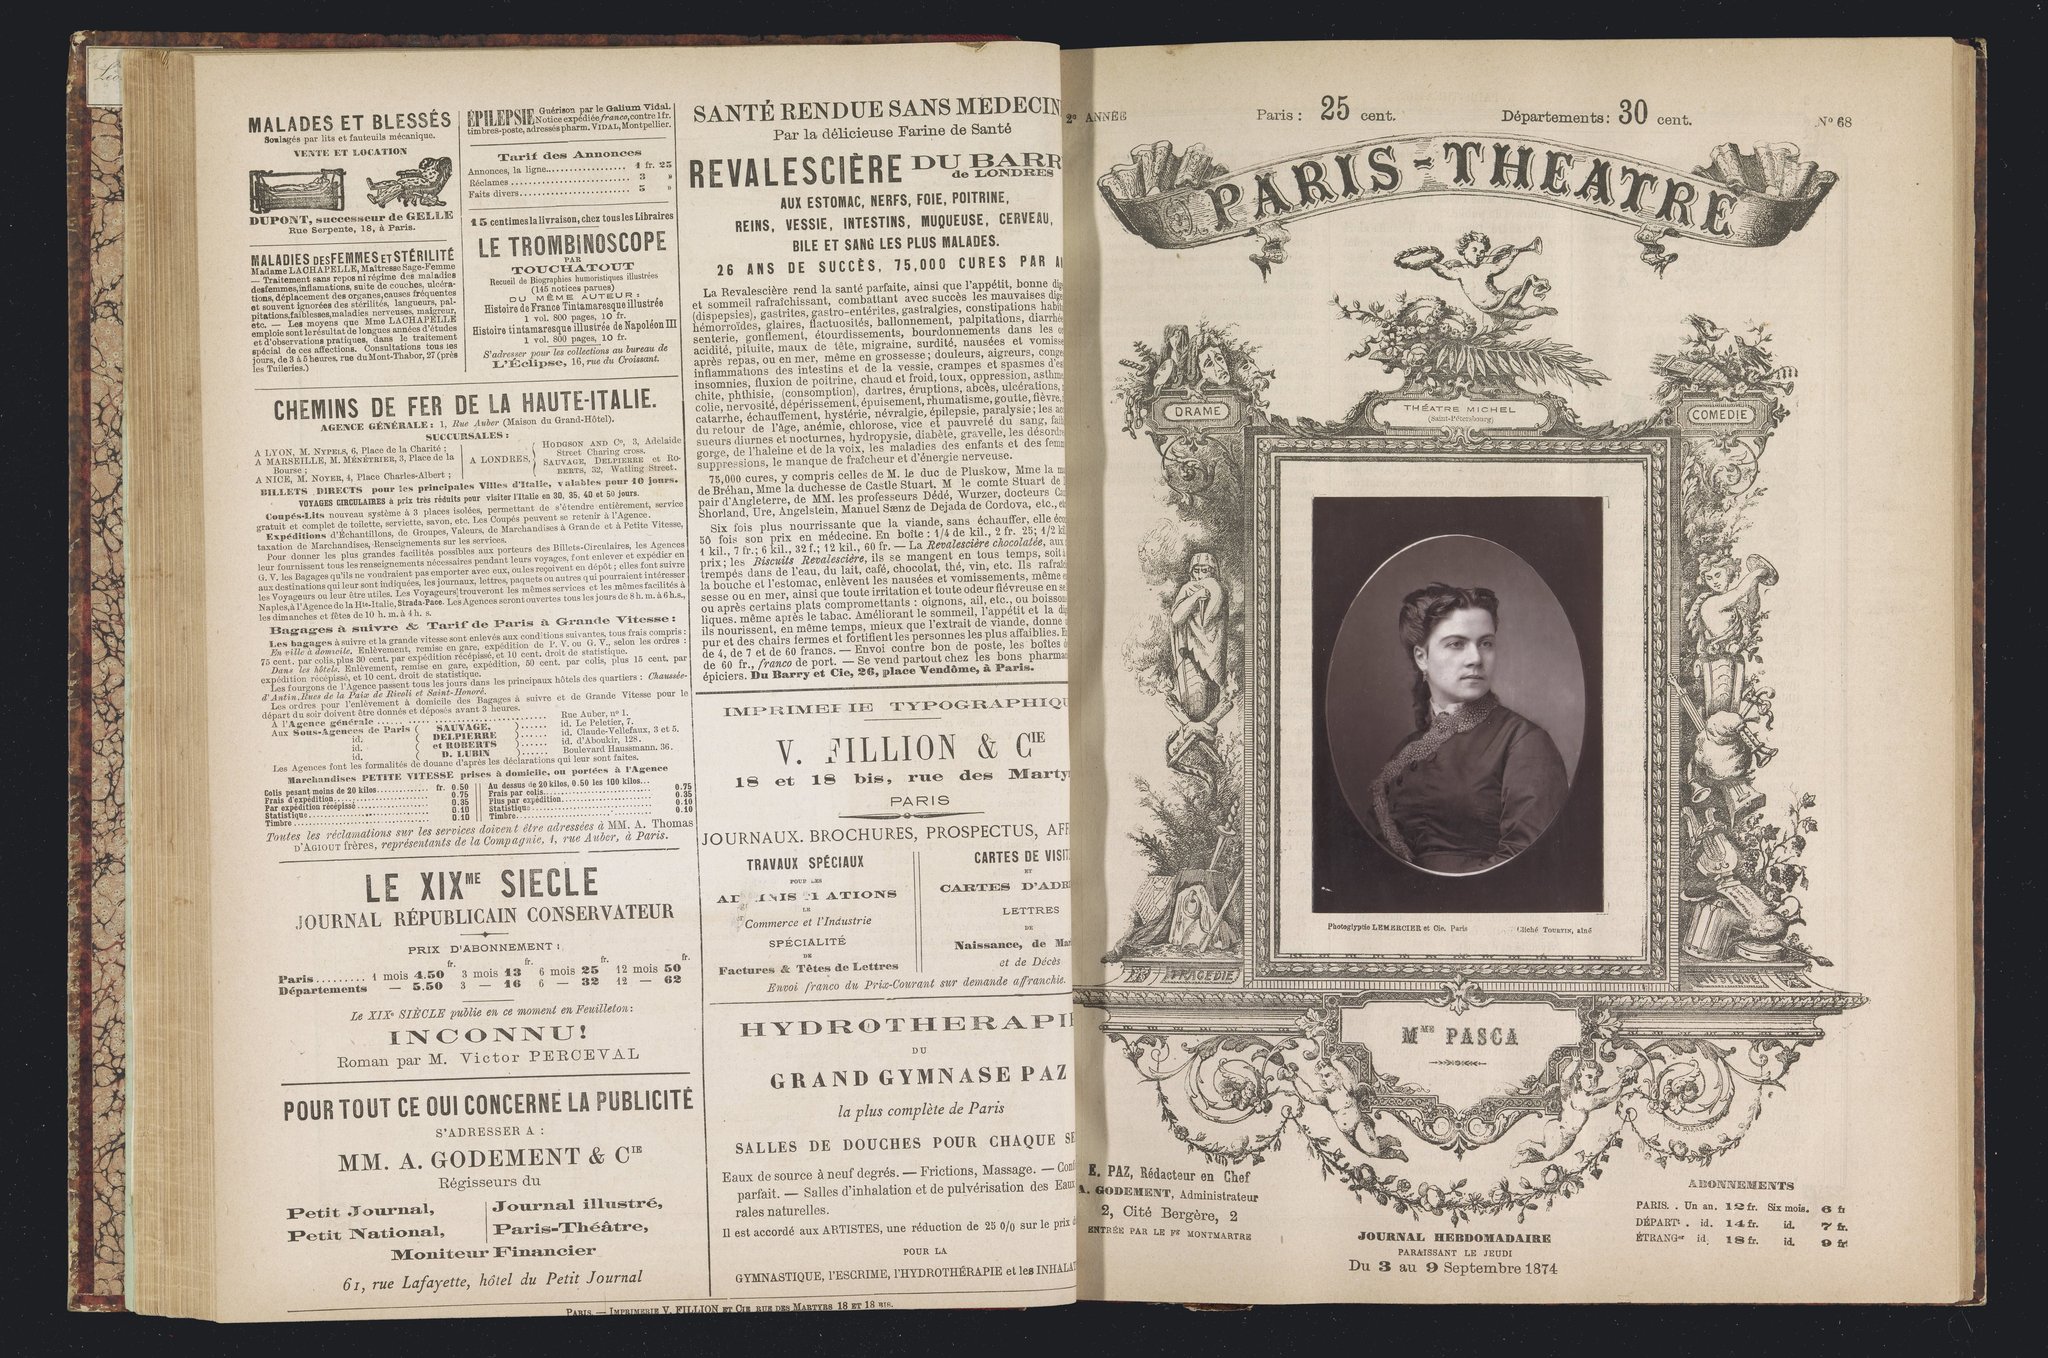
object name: photomechanical print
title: Portret van Madame Pasca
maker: j. tourtin (lainé)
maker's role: fotograaf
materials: paper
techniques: woodburytype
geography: paris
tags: lyon, paris, portrait of actor, actress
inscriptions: number: ‘No 68’, inscription: ‘Journal hebdomadaire paraissant le jeudi Du 3 au 9 Septembre 1874’